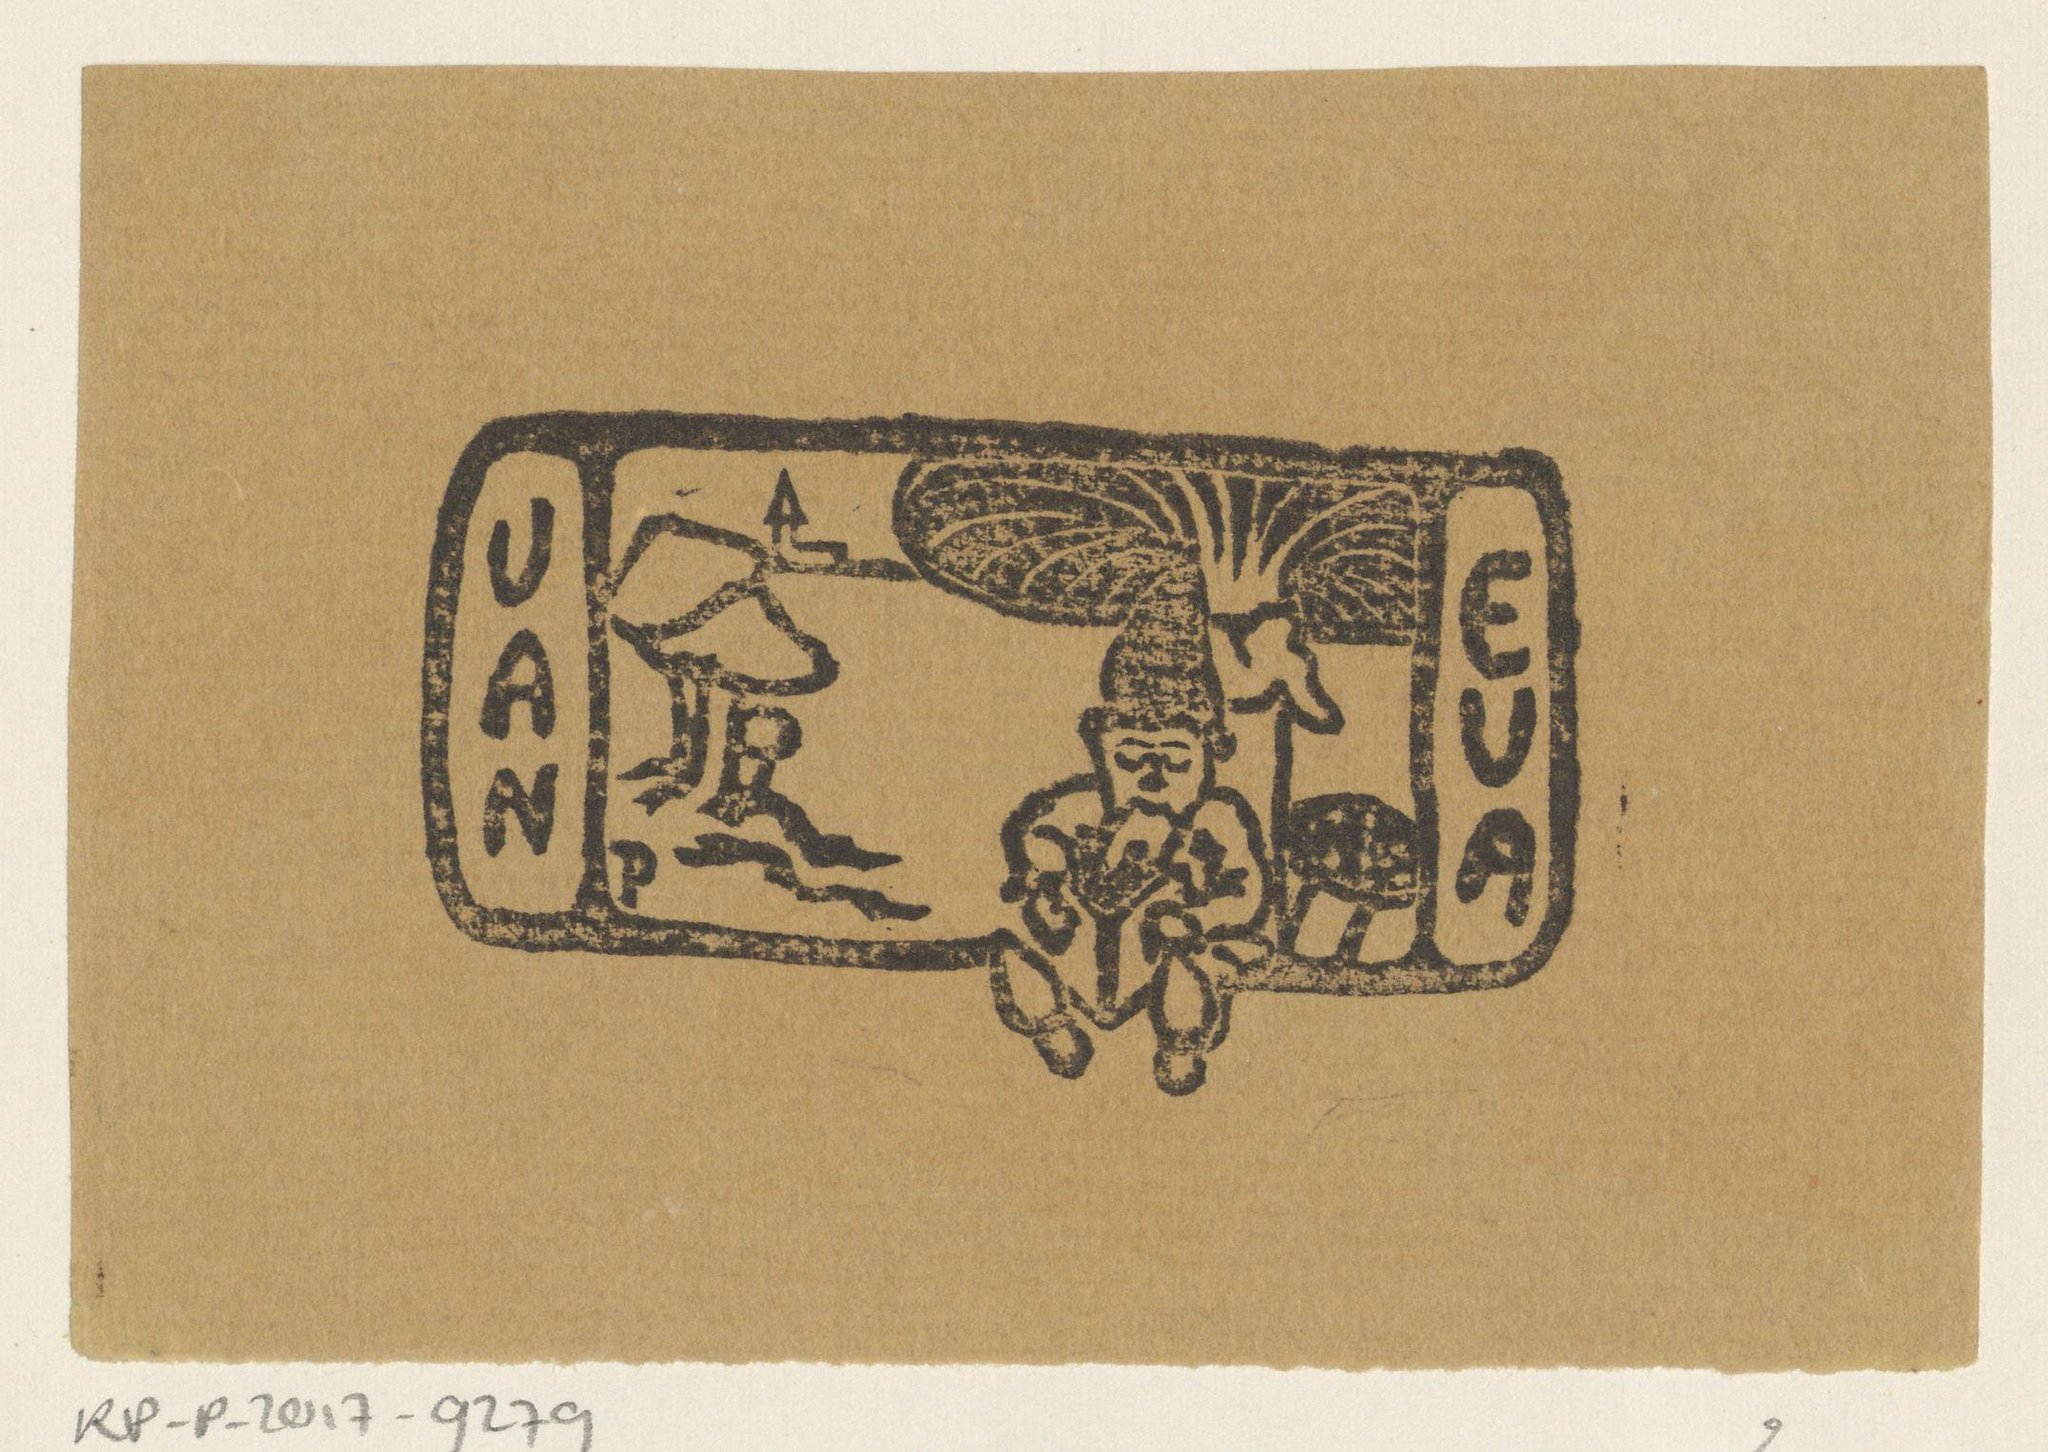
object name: bookplate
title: Ex libris van Jan en Eva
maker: Anonymous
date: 1900-1949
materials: paper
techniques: woodcut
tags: little people